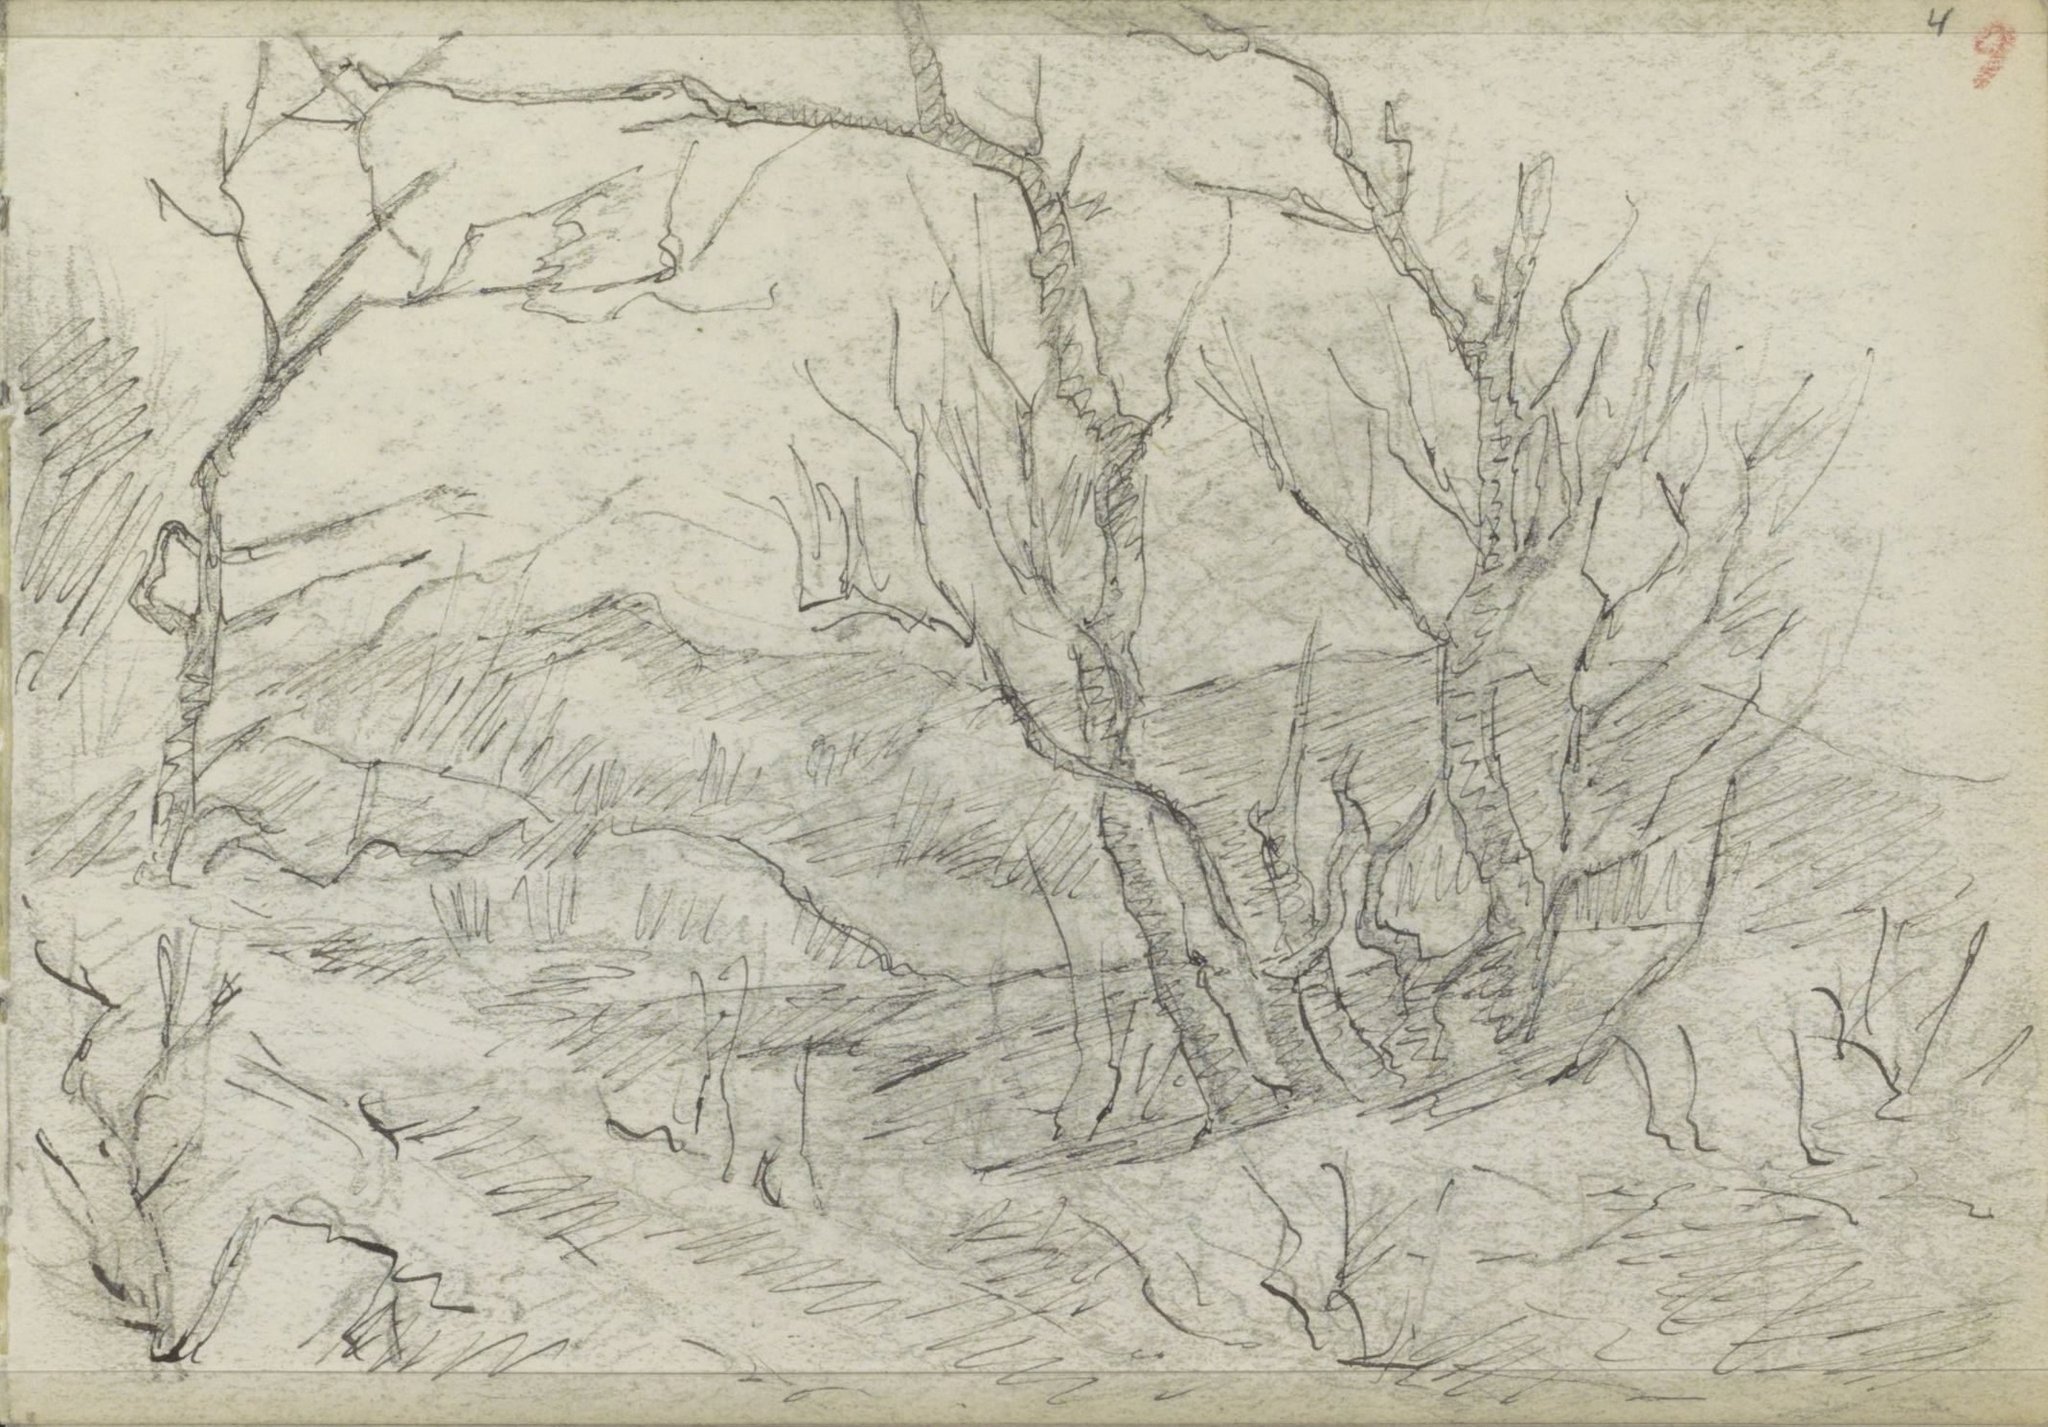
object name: sketchbook leaf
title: Heuvellandschap met een bomengroep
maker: jozef israëls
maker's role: draughtsman, painter, print maker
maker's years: 1824-1911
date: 1885-1902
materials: ink, paper, pencil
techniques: pen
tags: low hill country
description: Blad 4 recto uit een schetsboek met 17 bladen.